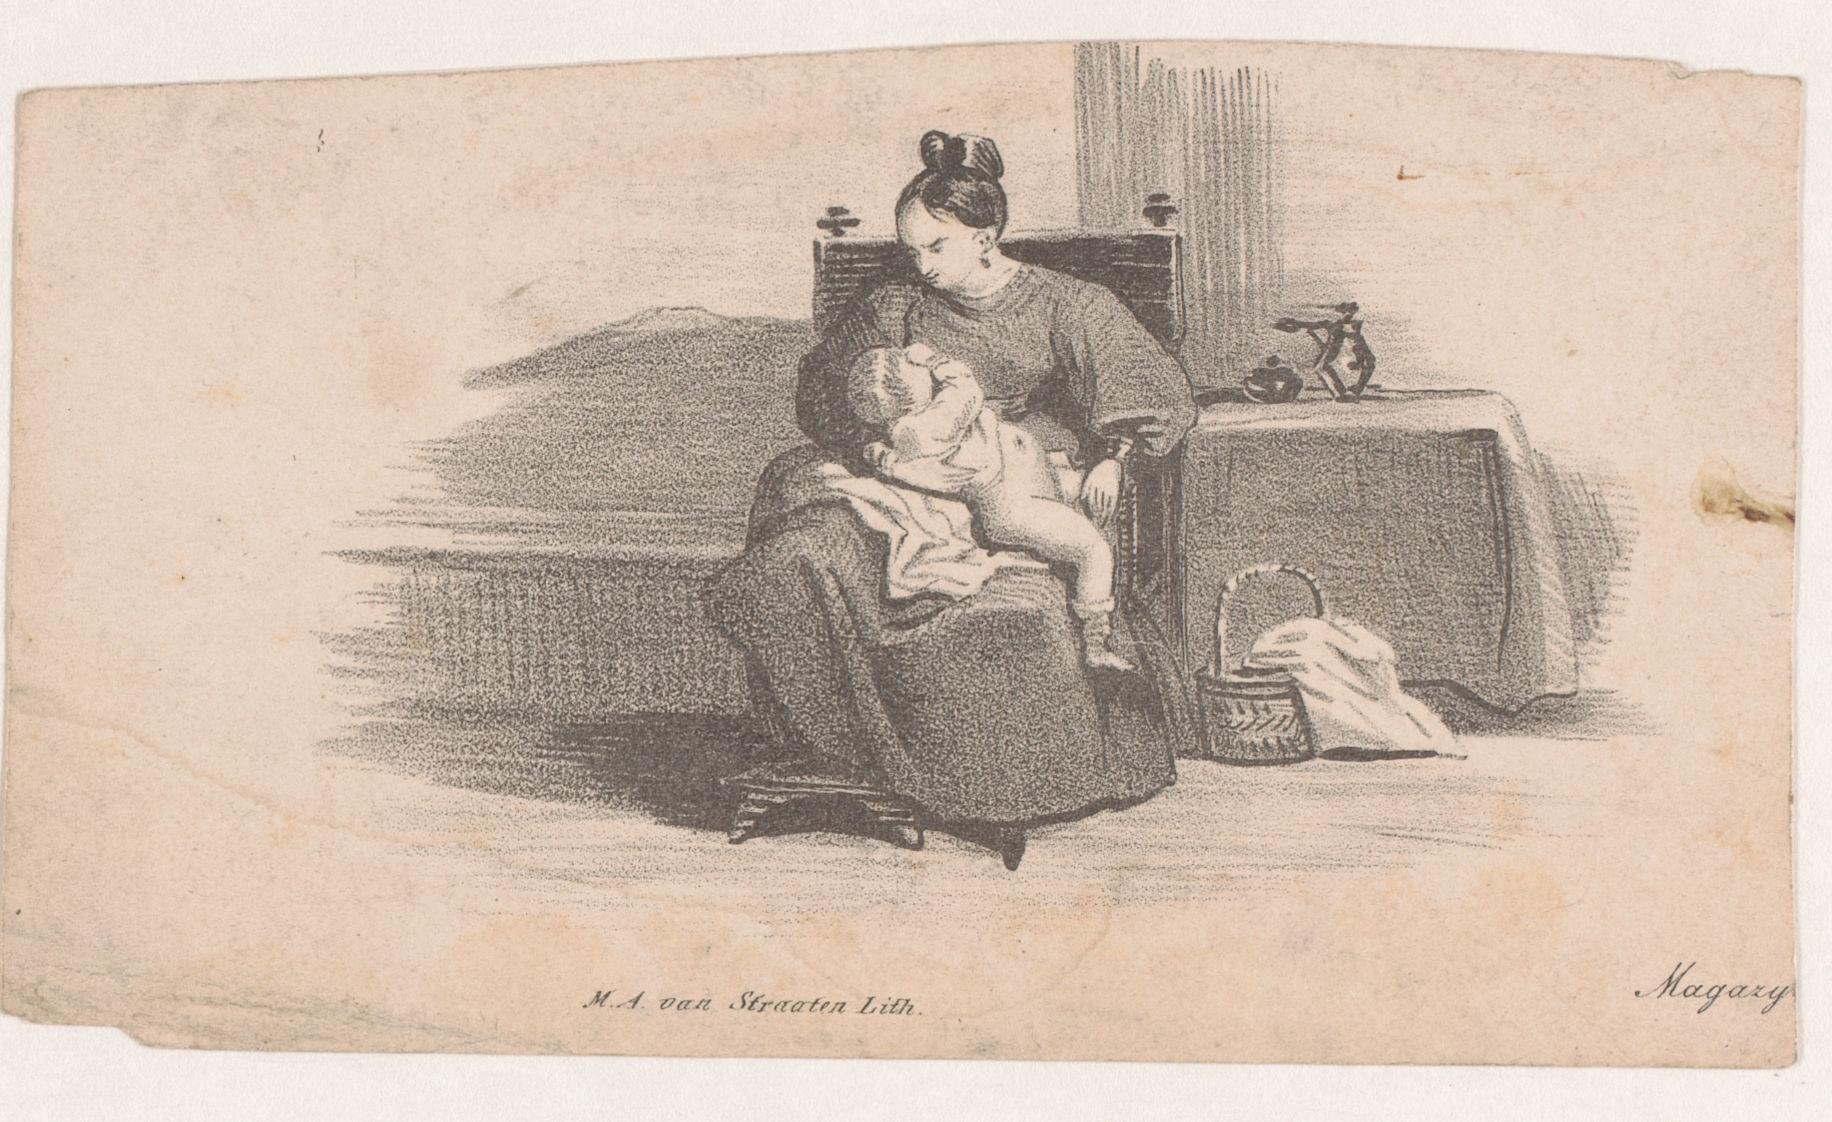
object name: print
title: Moeder met kind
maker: marinus adrianus van straten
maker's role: print maker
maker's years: 1808-1863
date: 1818-1863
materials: paper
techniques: lithograph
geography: utrecht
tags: mother and baby or young child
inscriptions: collector's mark: Lugt 2228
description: Een moeder zit met een naakt kind op schoot.